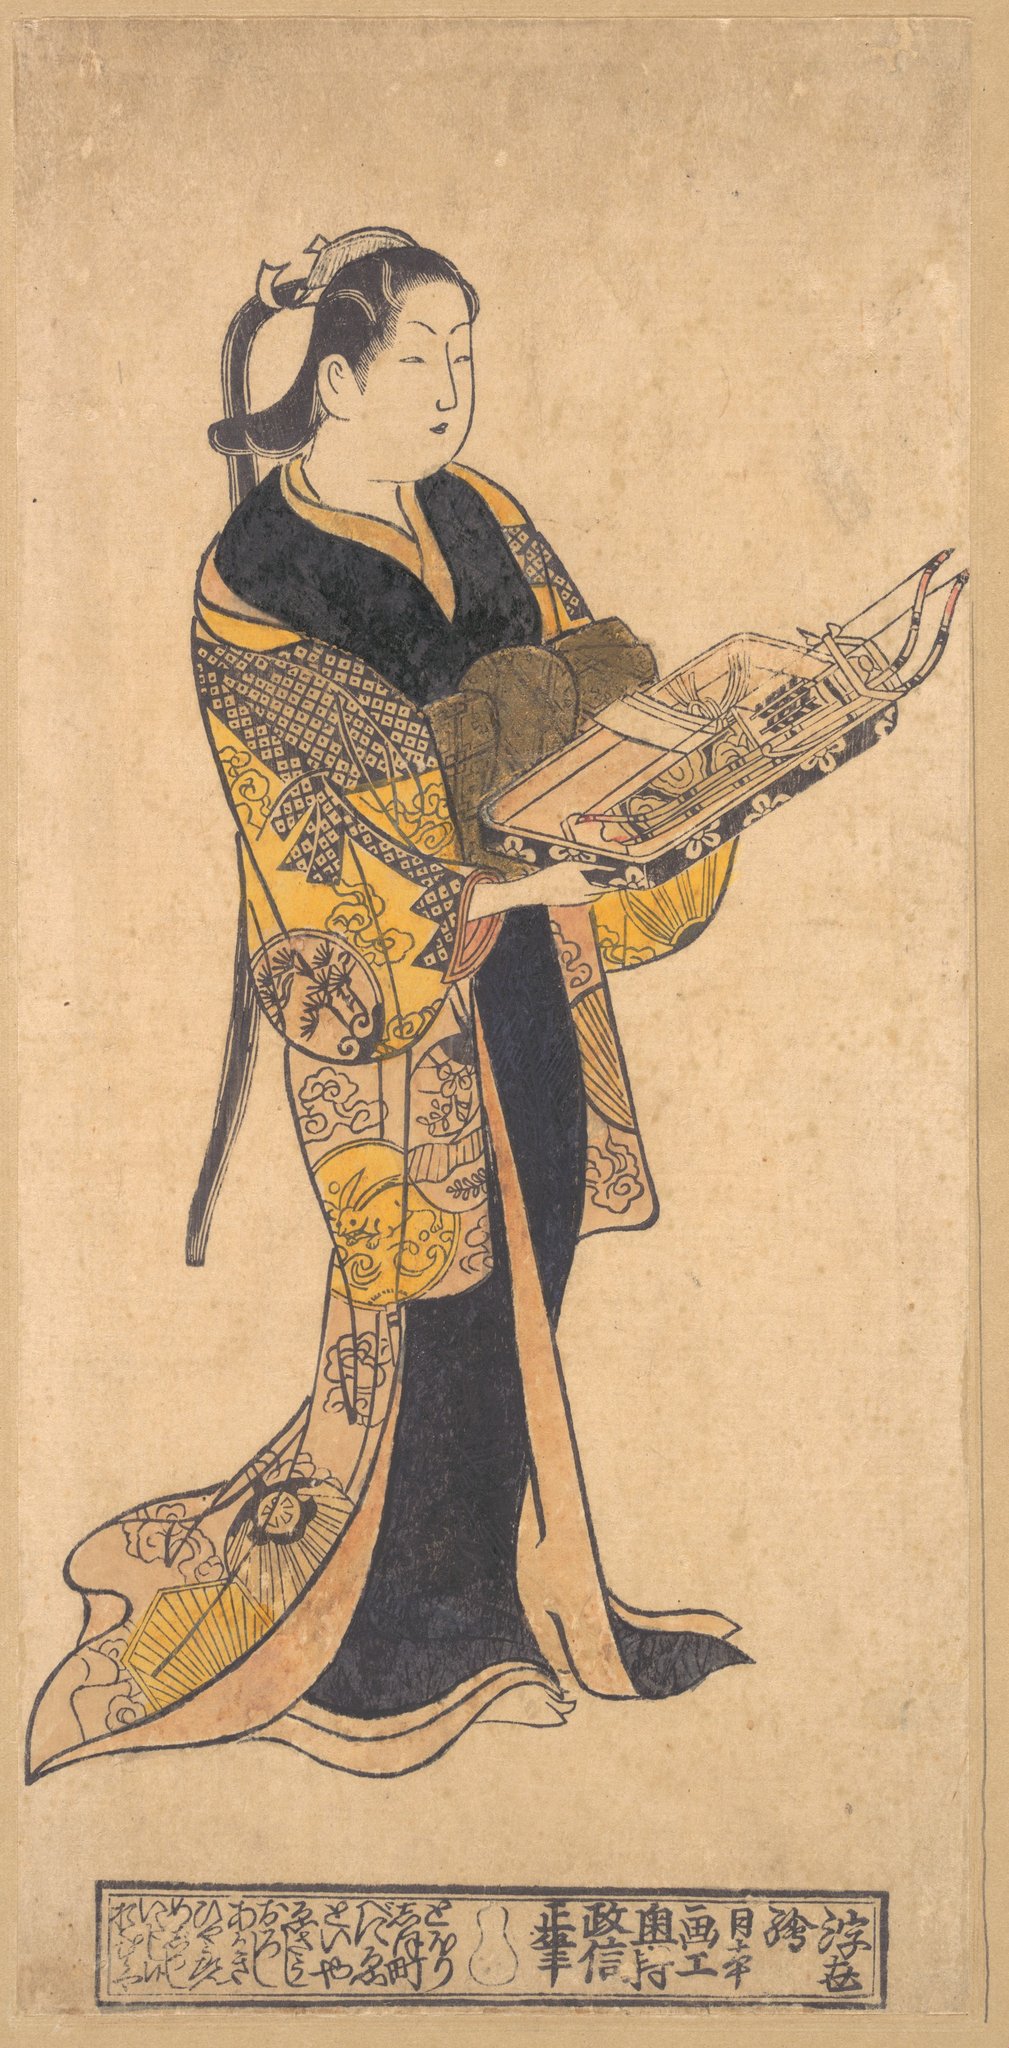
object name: print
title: Woman with Toys for the Boys' Festival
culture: japanese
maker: okumura masanobu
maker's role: artist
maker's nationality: japanese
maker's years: 1686-1764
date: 1730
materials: ink, paper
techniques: hand coloring, woodblock print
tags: women,toys